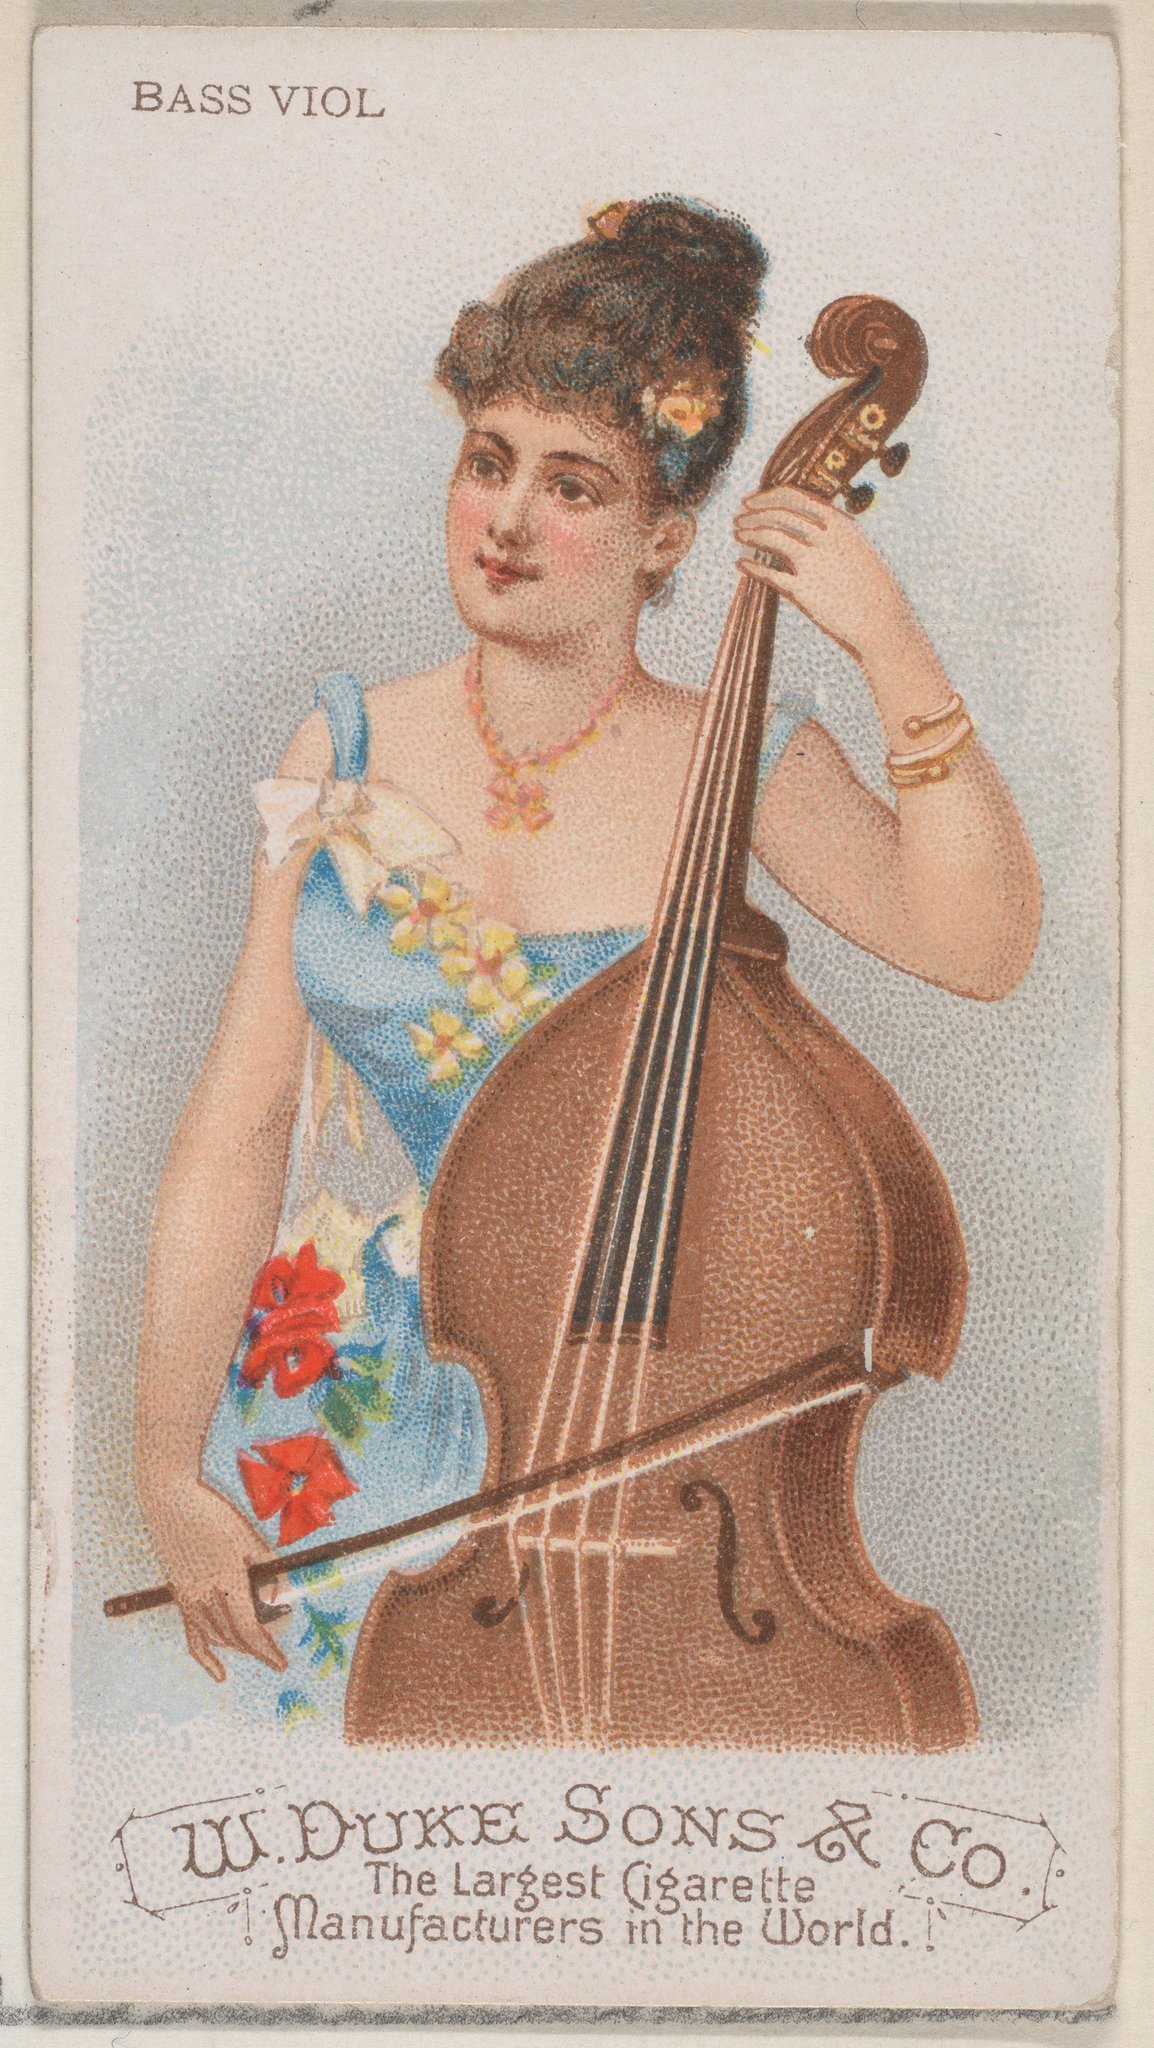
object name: print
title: Bass Viol, from the Musical Instruments series (N82) for Duke brand cigarettes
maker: w. duke, sons & co.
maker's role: publisher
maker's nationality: american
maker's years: 1870-1920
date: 1888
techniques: color lithograph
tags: musical instruments,women,musicians